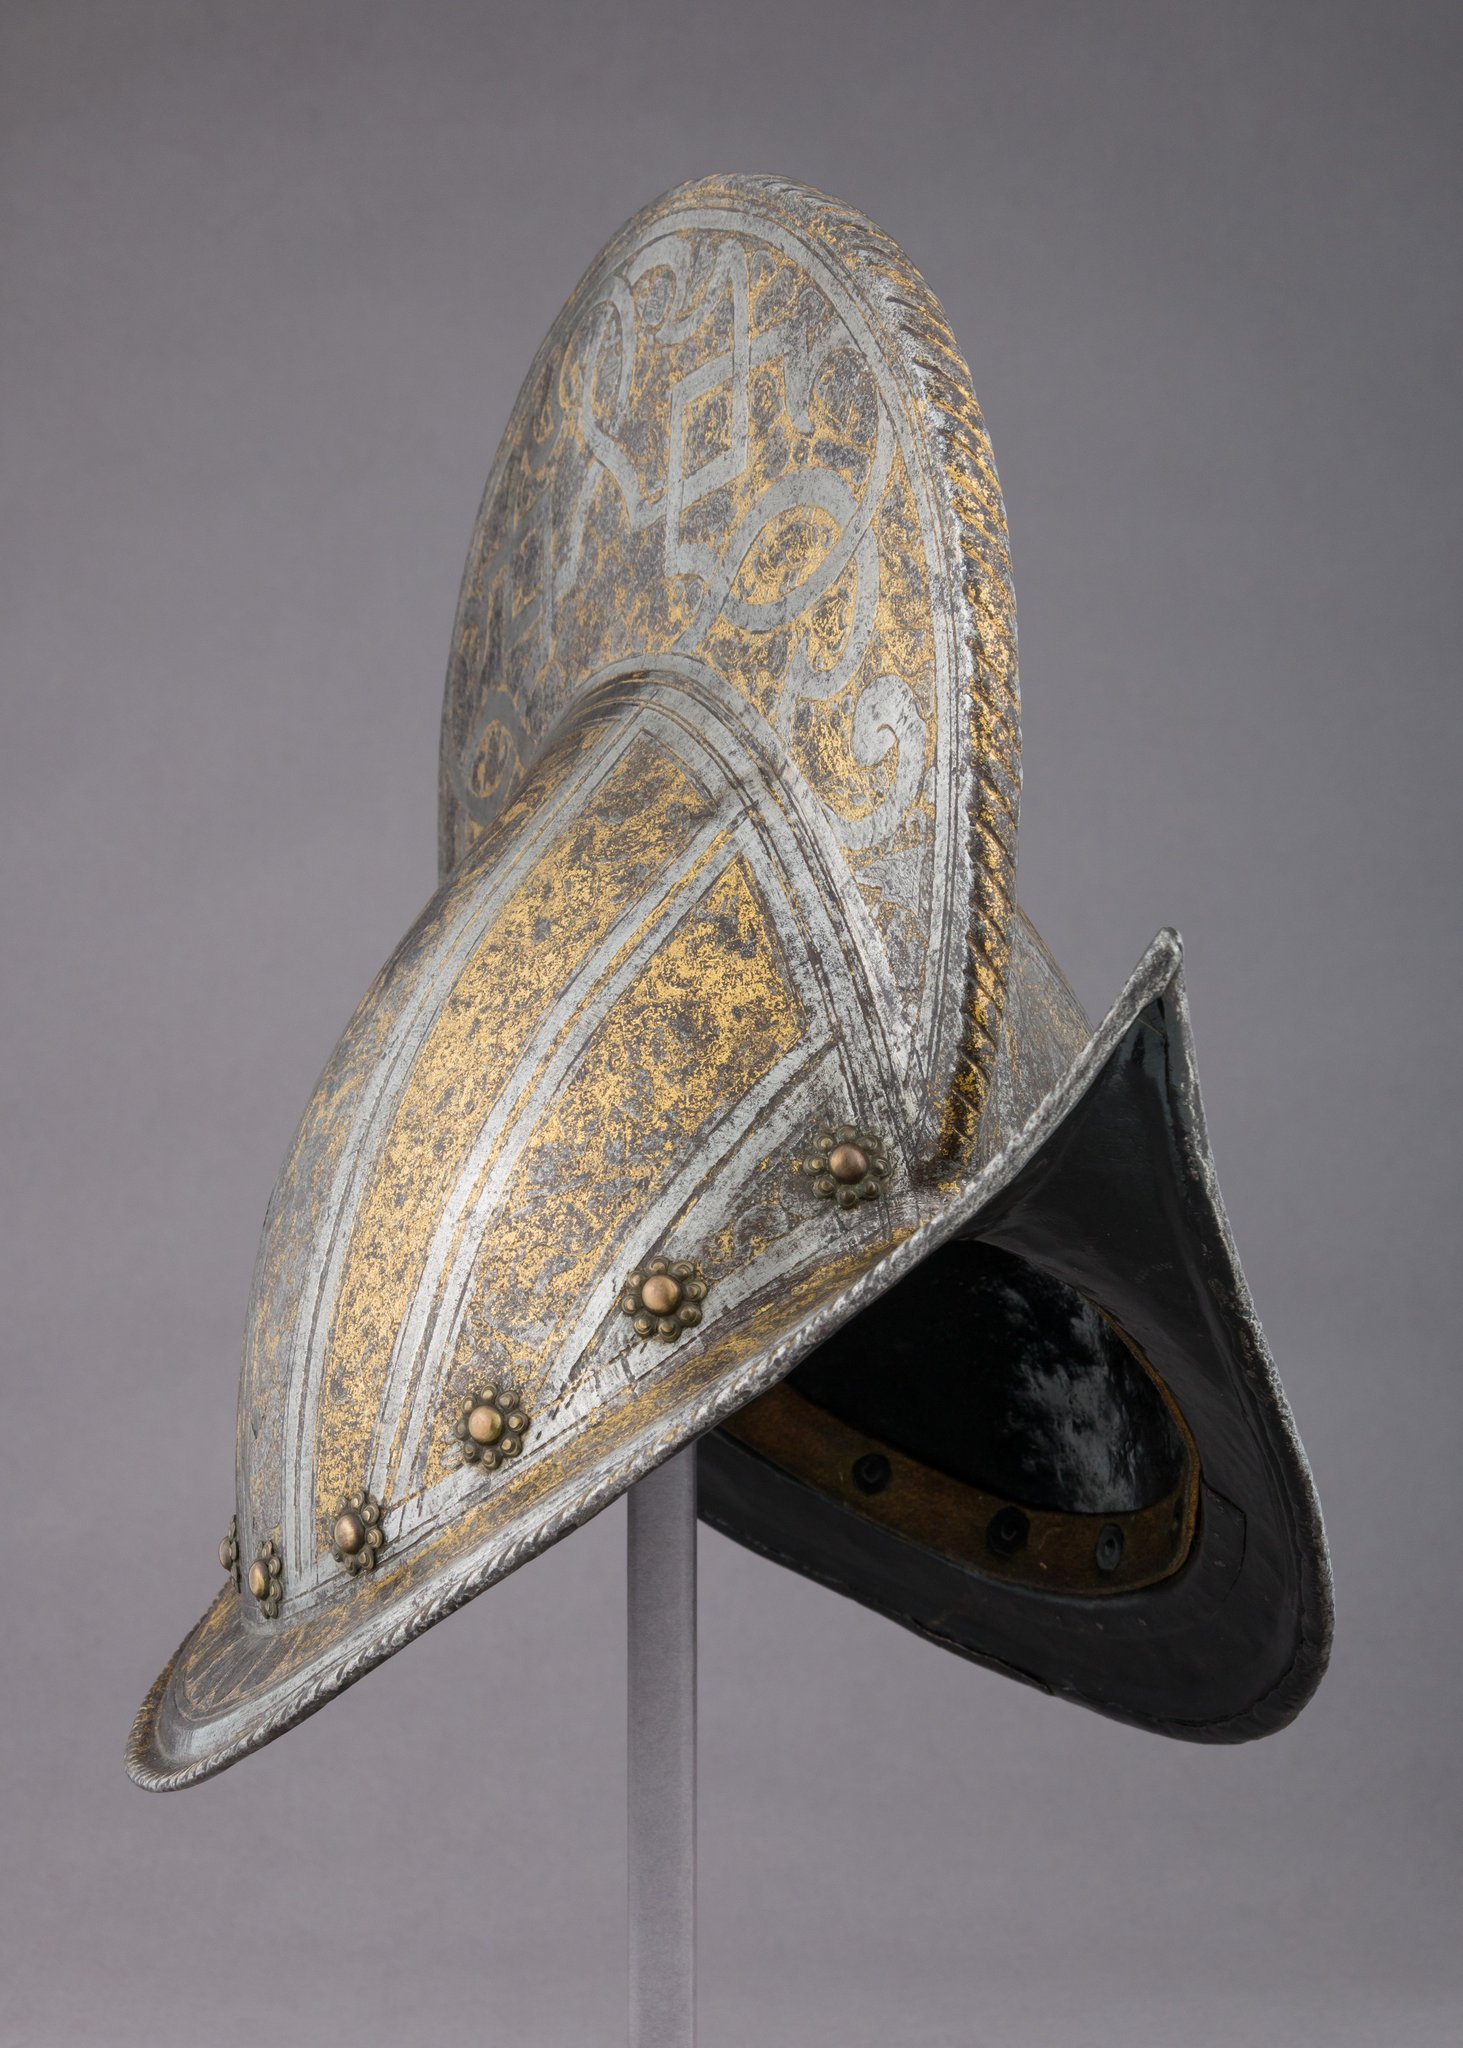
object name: morion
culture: french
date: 1575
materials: brass, gold, leather, steel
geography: france